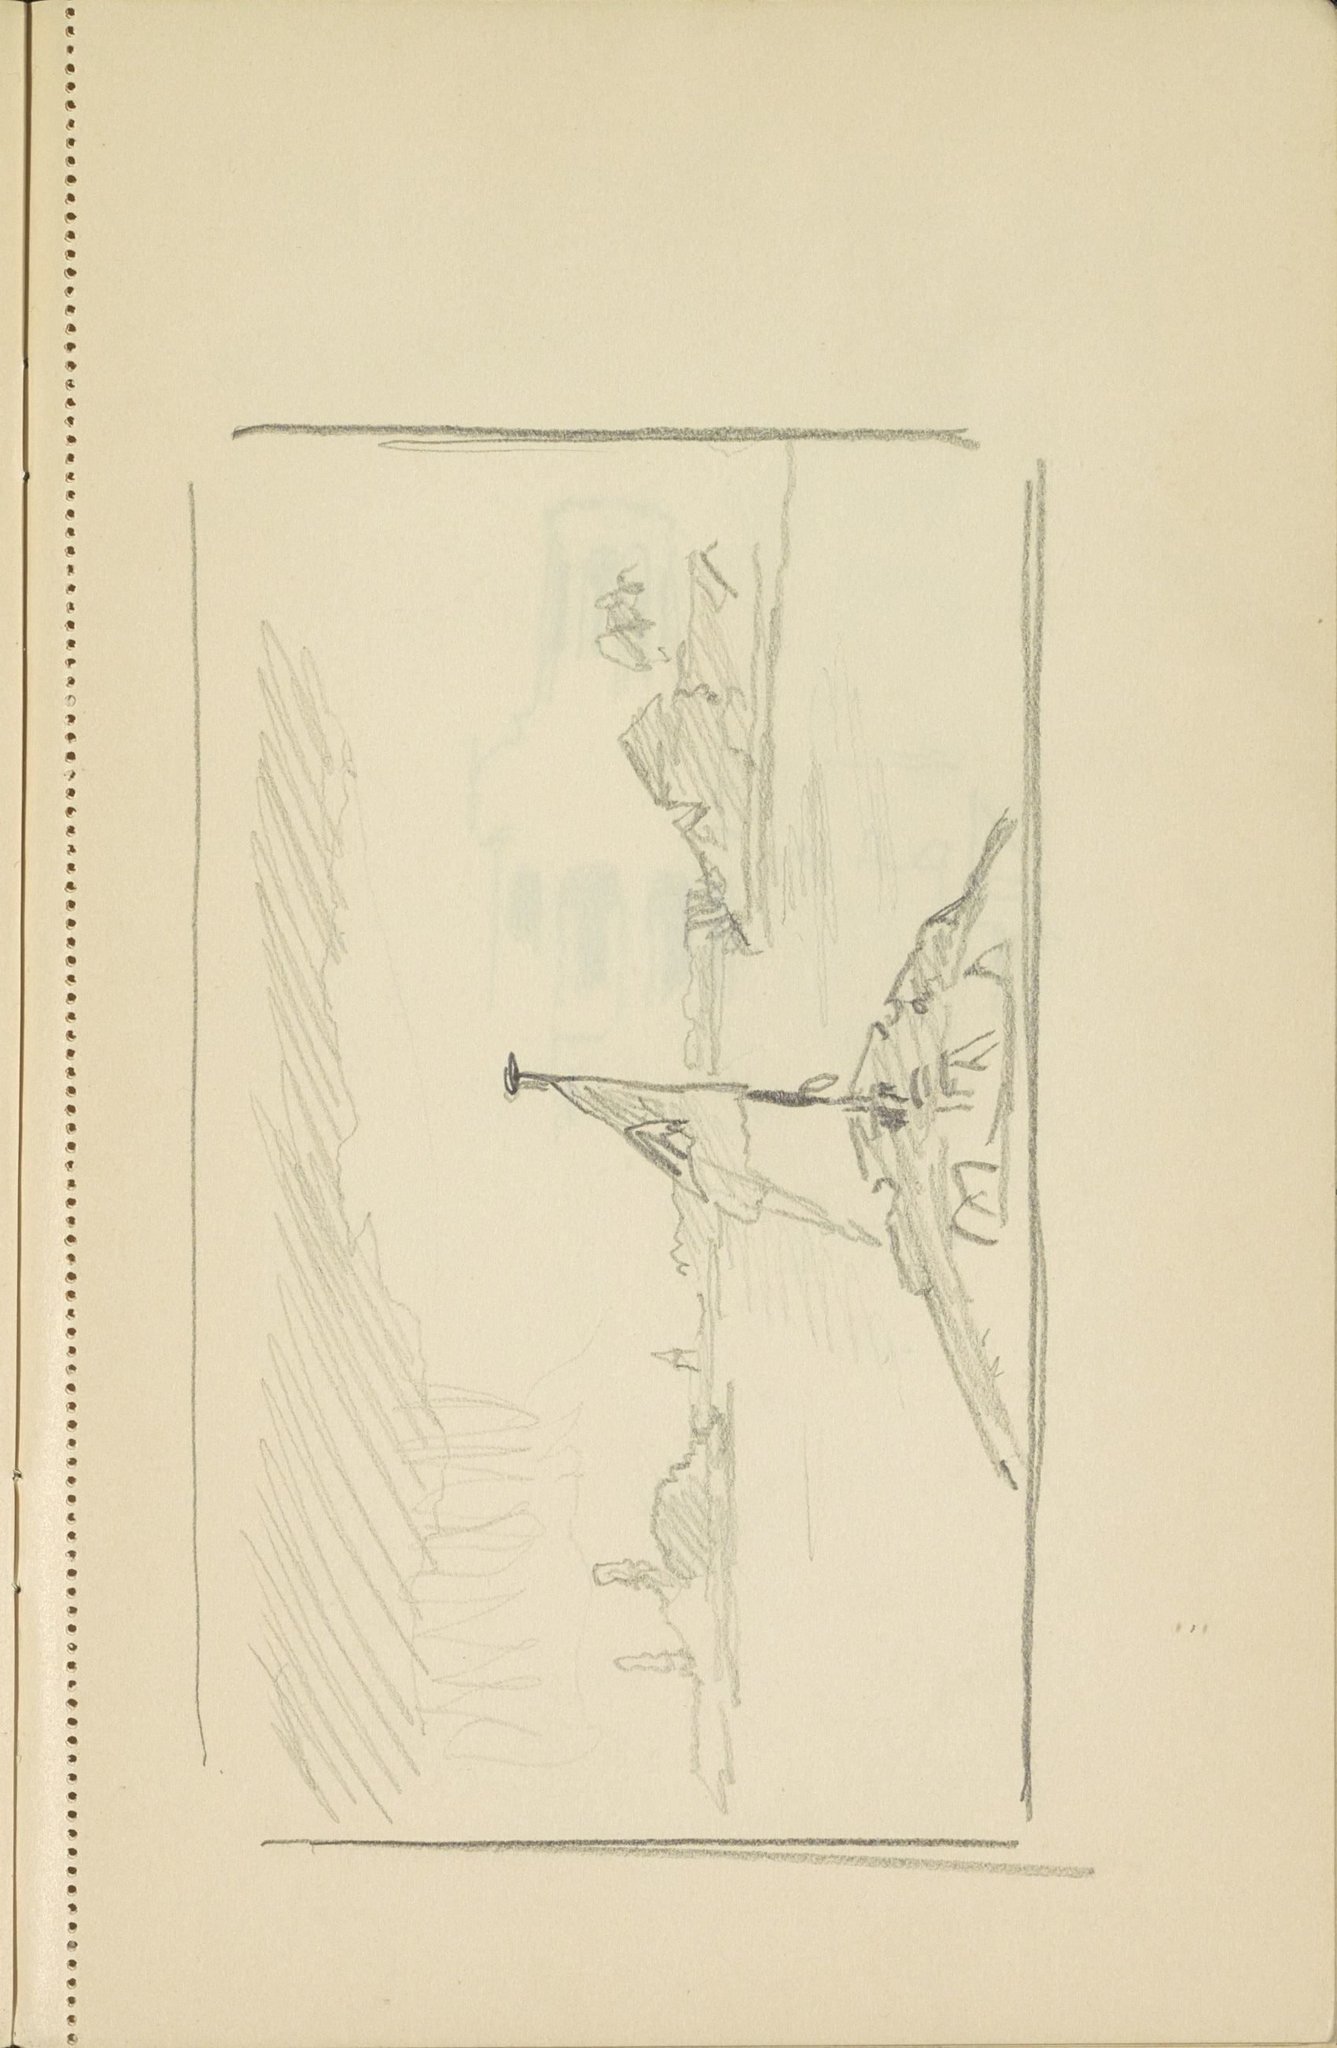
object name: sketchbook leaf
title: Landschap met water, gezien vanaf de boeg van een schip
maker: cornelis vreedenburgh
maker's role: draughtsman, print maker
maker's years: 1880-1946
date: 1890-1946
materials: paper, pencil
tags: parts of ship's exterior: bow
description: Blad 61 recto uit een schetsboek met 73 bladen.